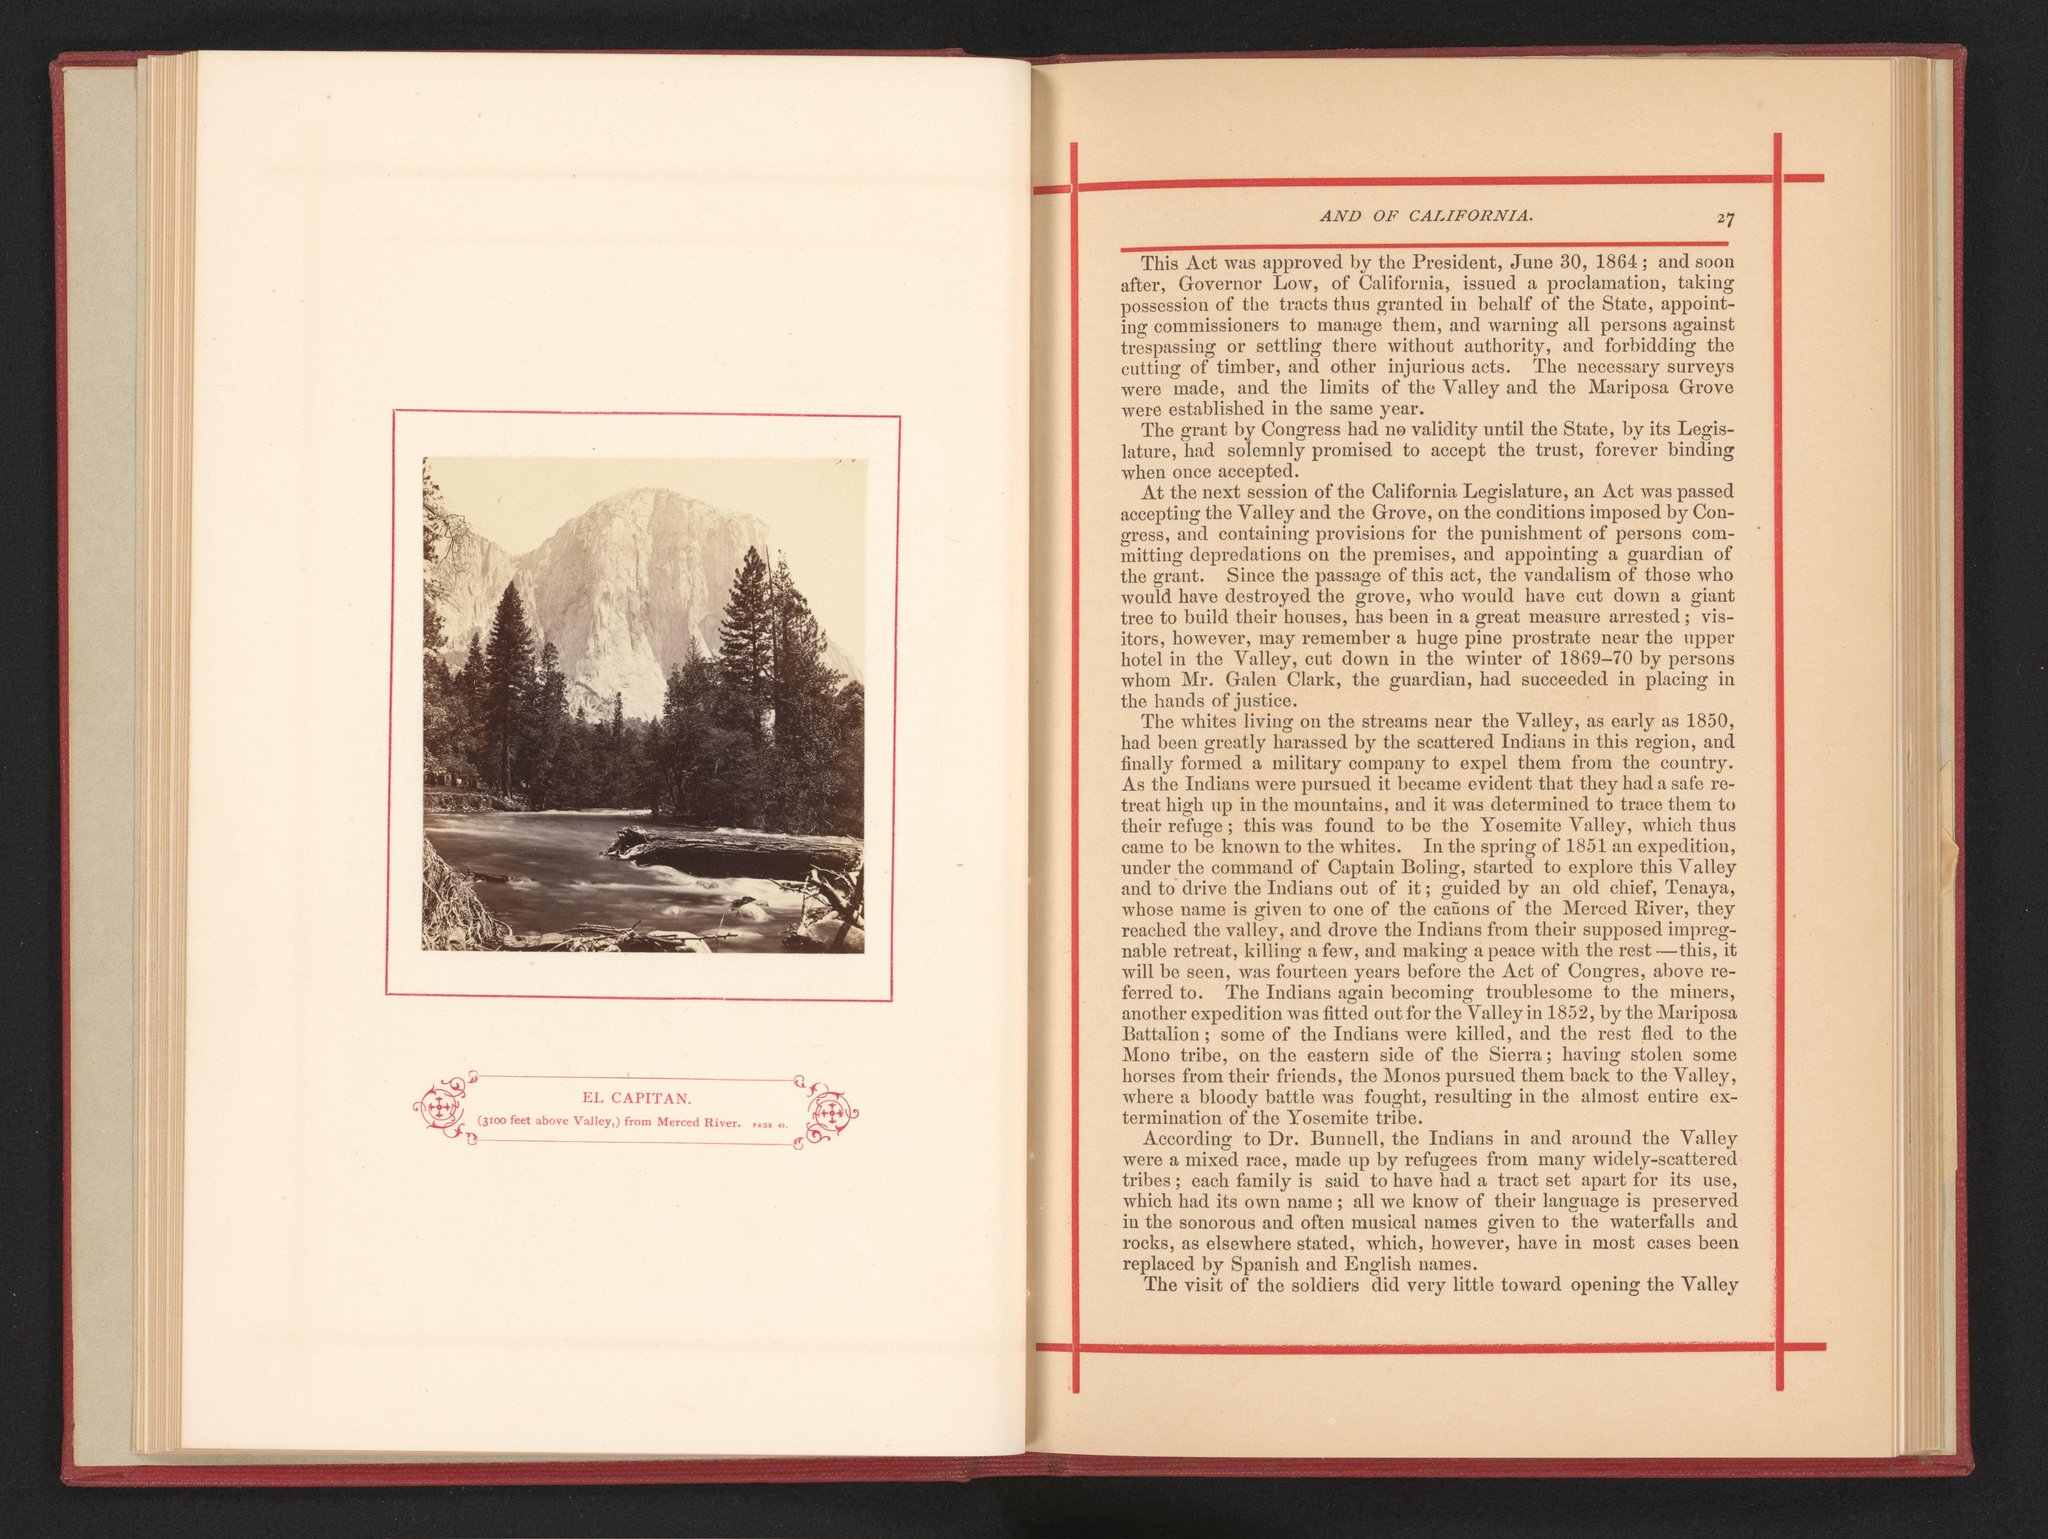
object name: photograph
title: El Capitan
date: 1861-1871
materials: photographic support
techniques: albumen print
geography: yosemite valley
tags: river, mountains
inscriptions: inscription: ‘(3100 feet above Valley,) from Merced River. Page 41.’